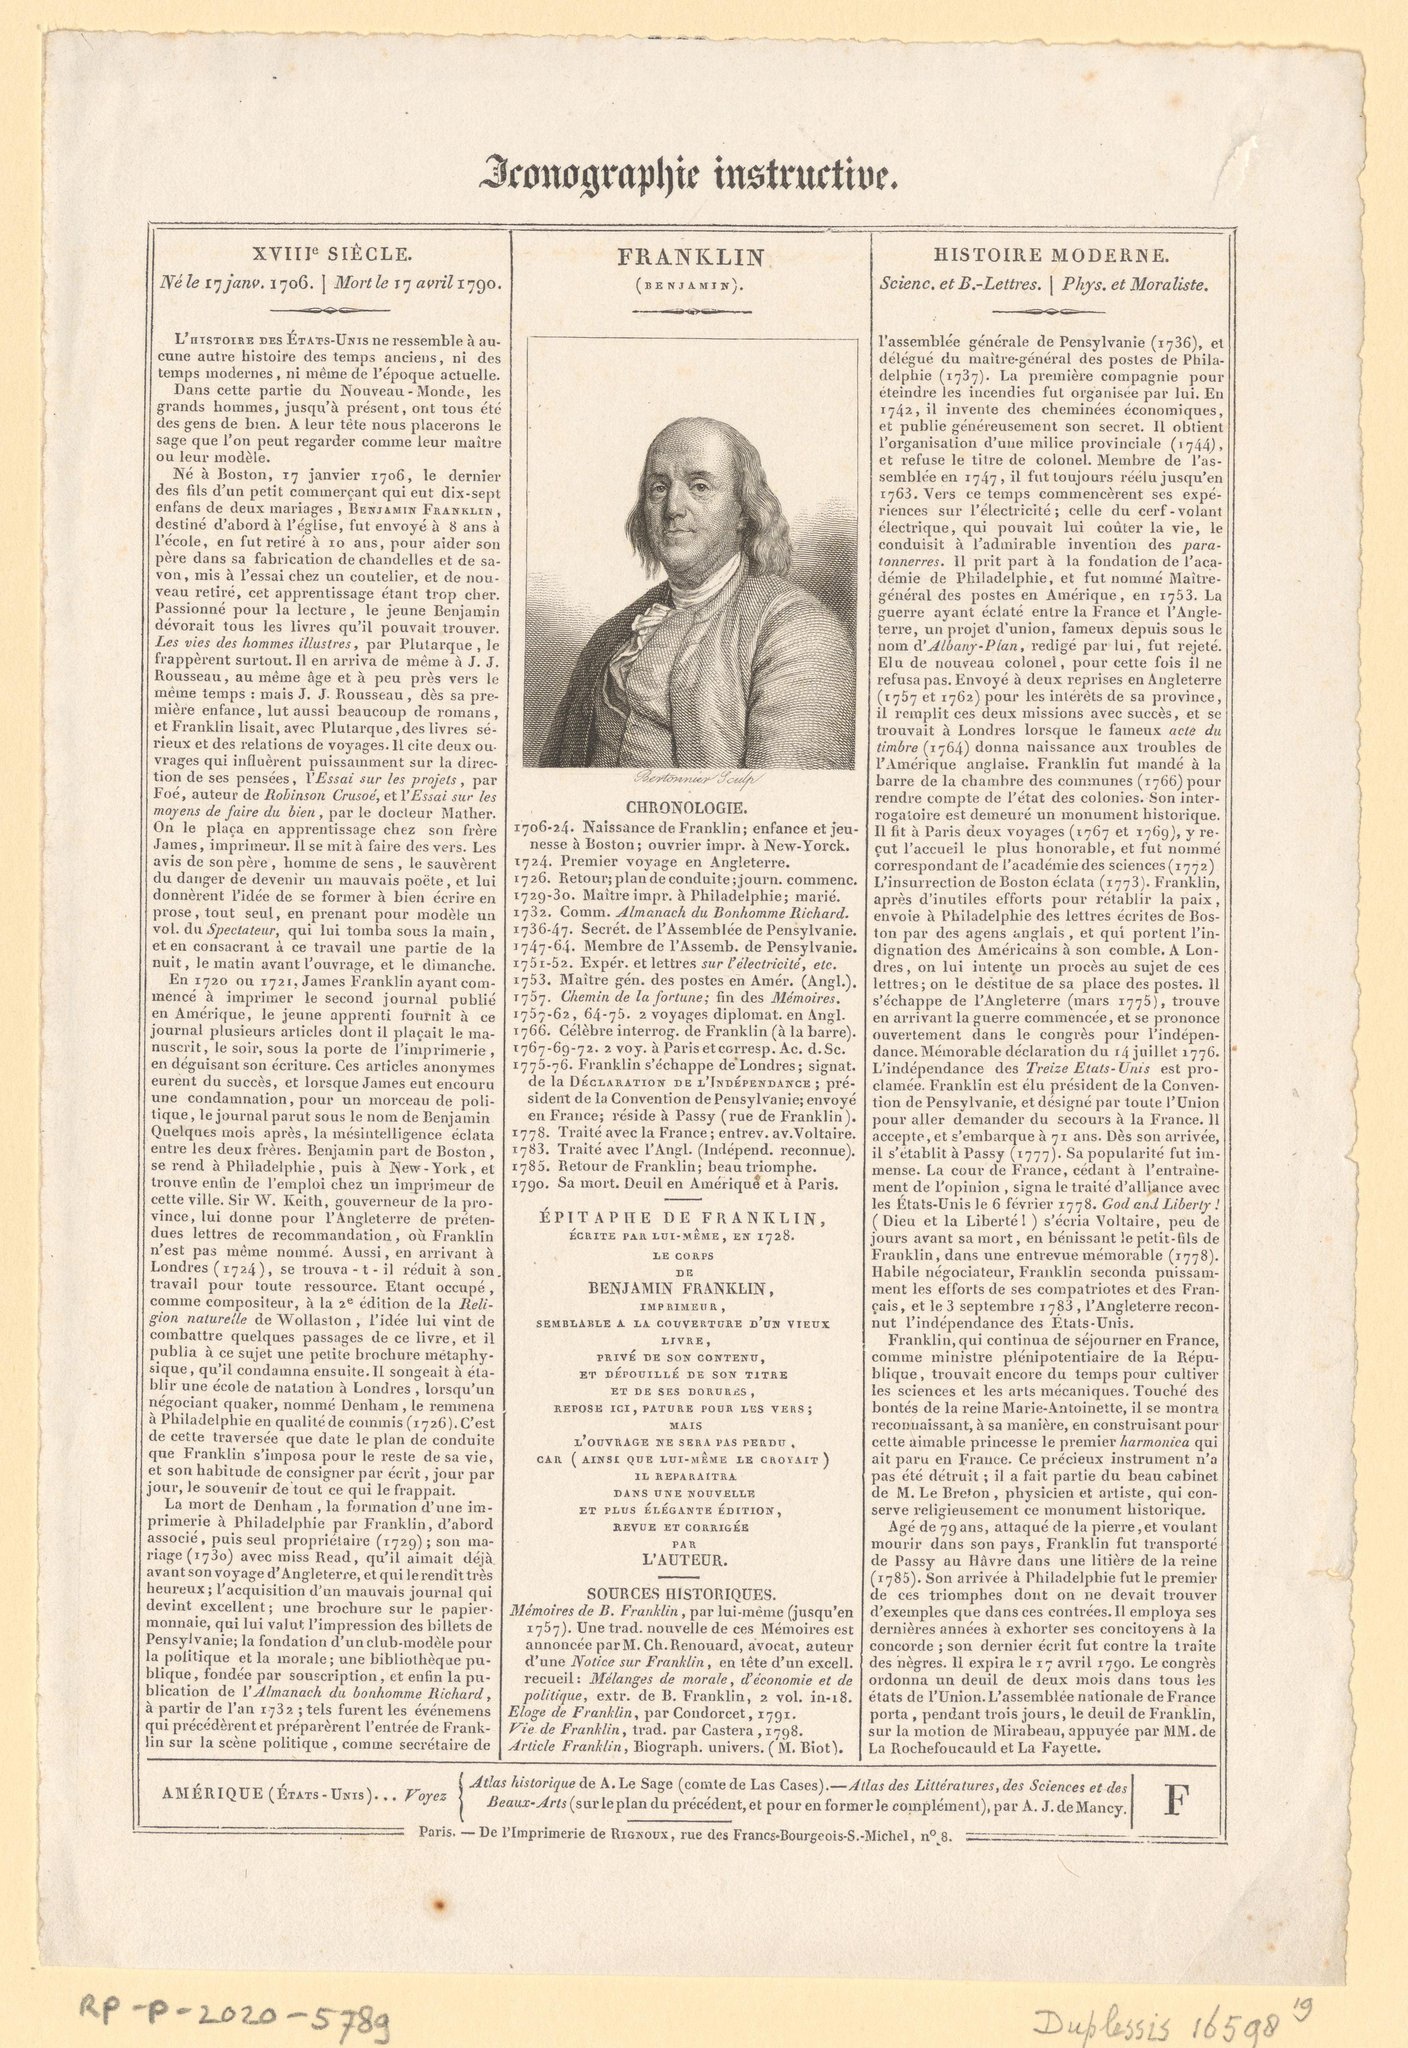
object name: text sheet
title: Portret van Benjamin Franklin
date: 1827-1829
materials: paper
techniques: etching, letterpress printing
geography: paris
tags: physicist, historical persons